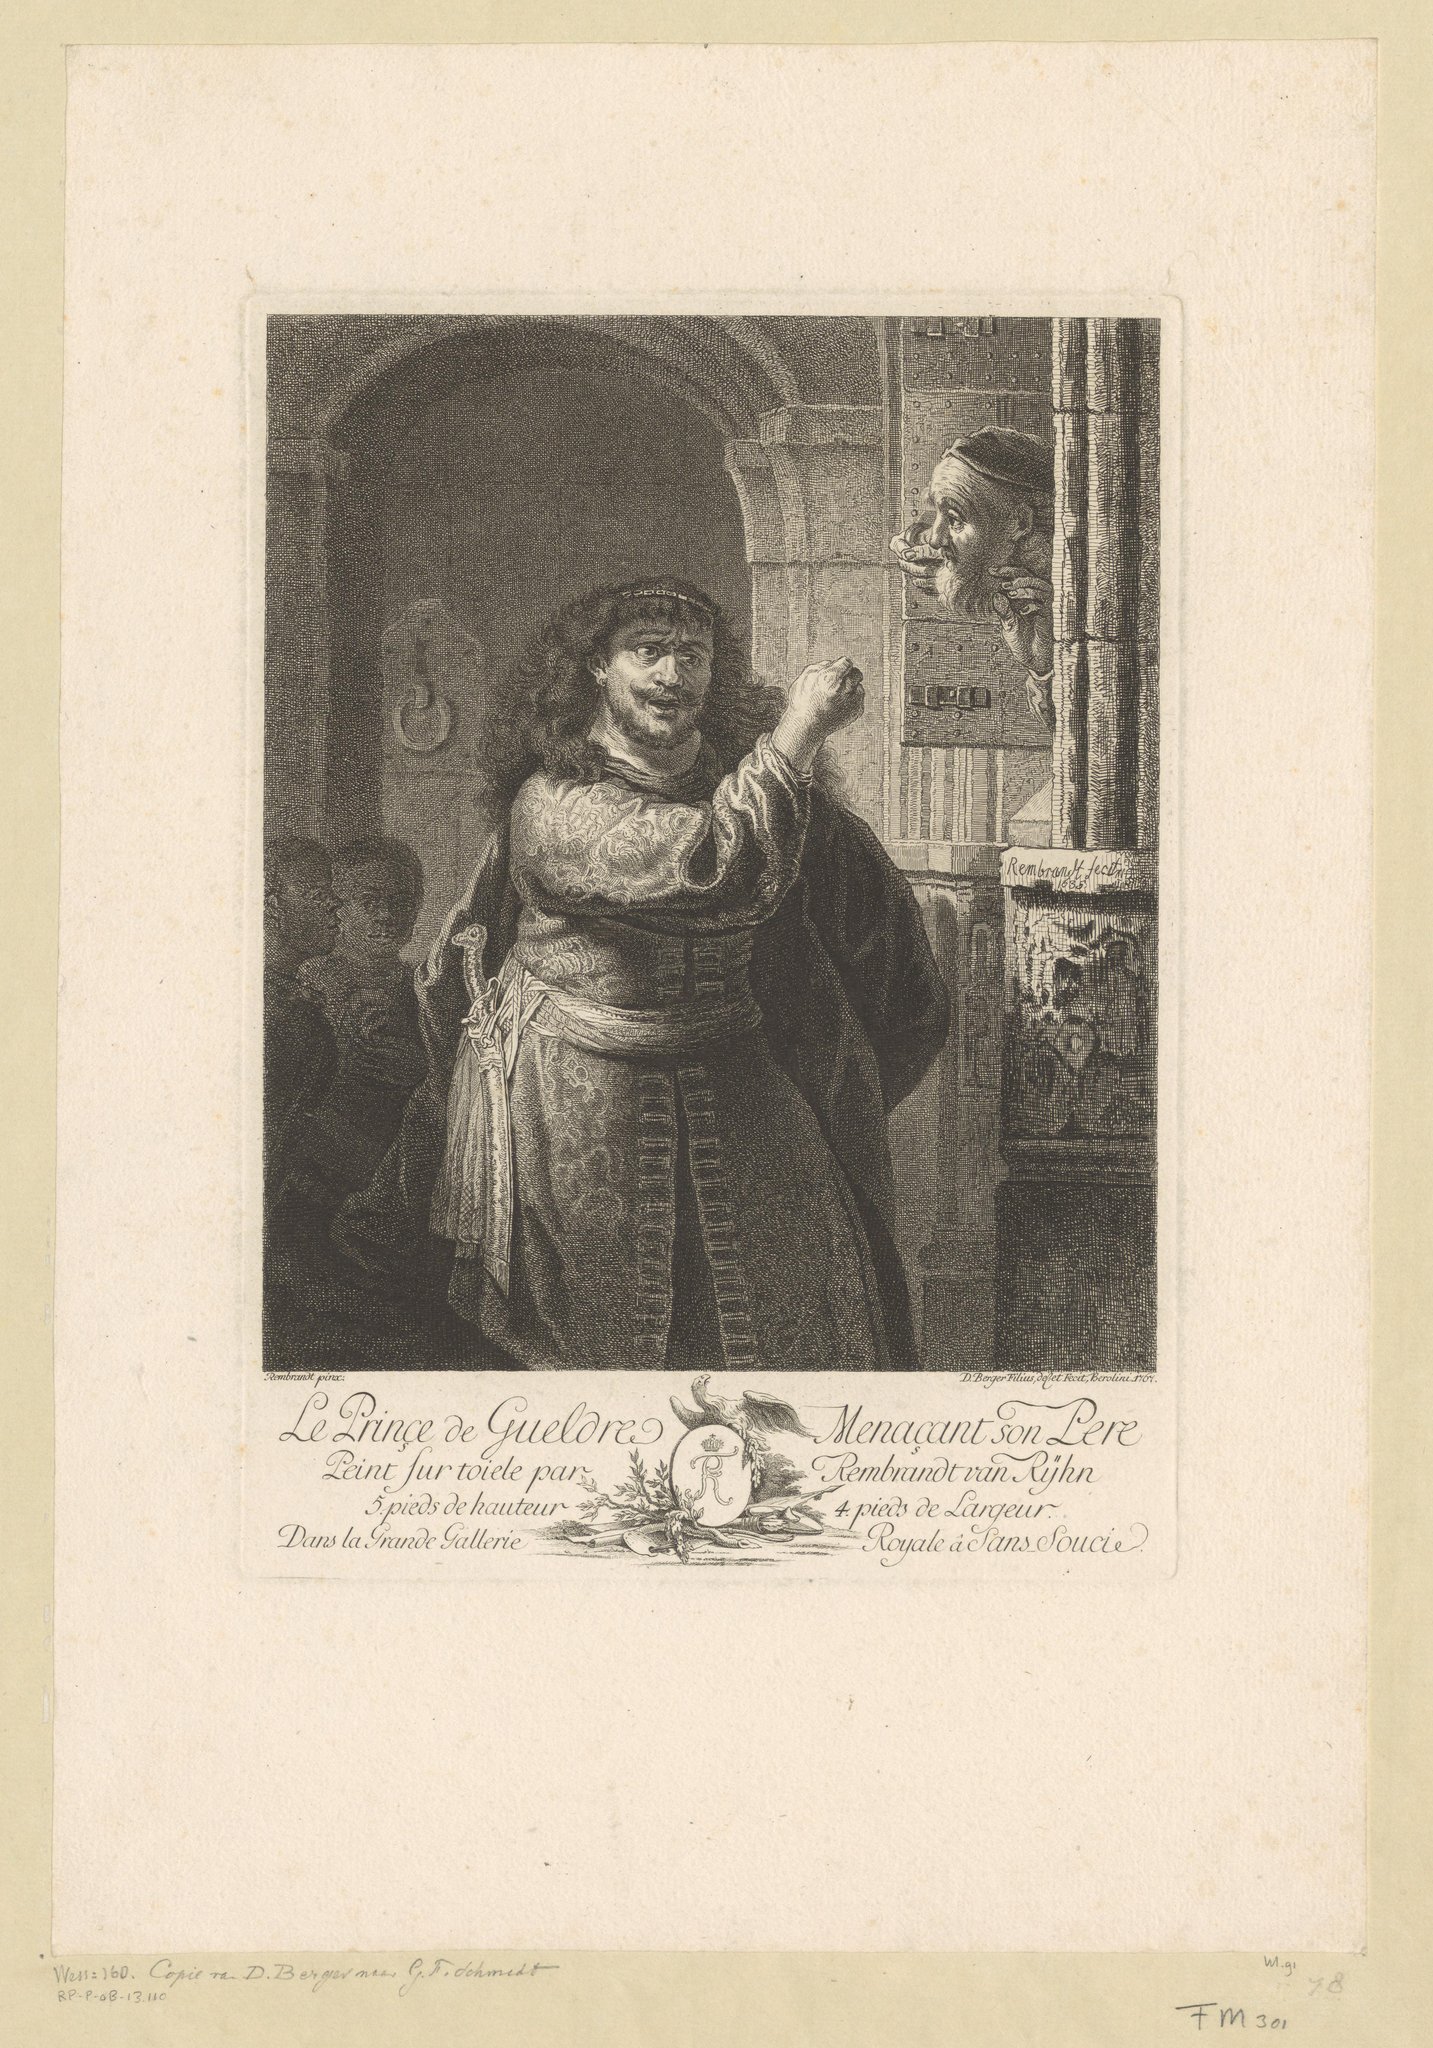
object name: history print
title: Adolf van Gelre bedreigt zijn vader die in de gevangenis zit, 1465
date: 1767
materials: paper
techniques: etching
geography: berlin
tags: netherlands, burgundian netherlands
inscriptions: collector's mark: Lugt 240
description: Adolf van Egmond, hertog van Gelre bedreigt zijn vader Arnold van Egmond, hertog van Gelre, die in de gevangenis zit, 1465. Het onderwerp van deze voorstelling wordt tegenwoordig geïnterpreteerd als Simson die zijn schoonvader bedreigt.